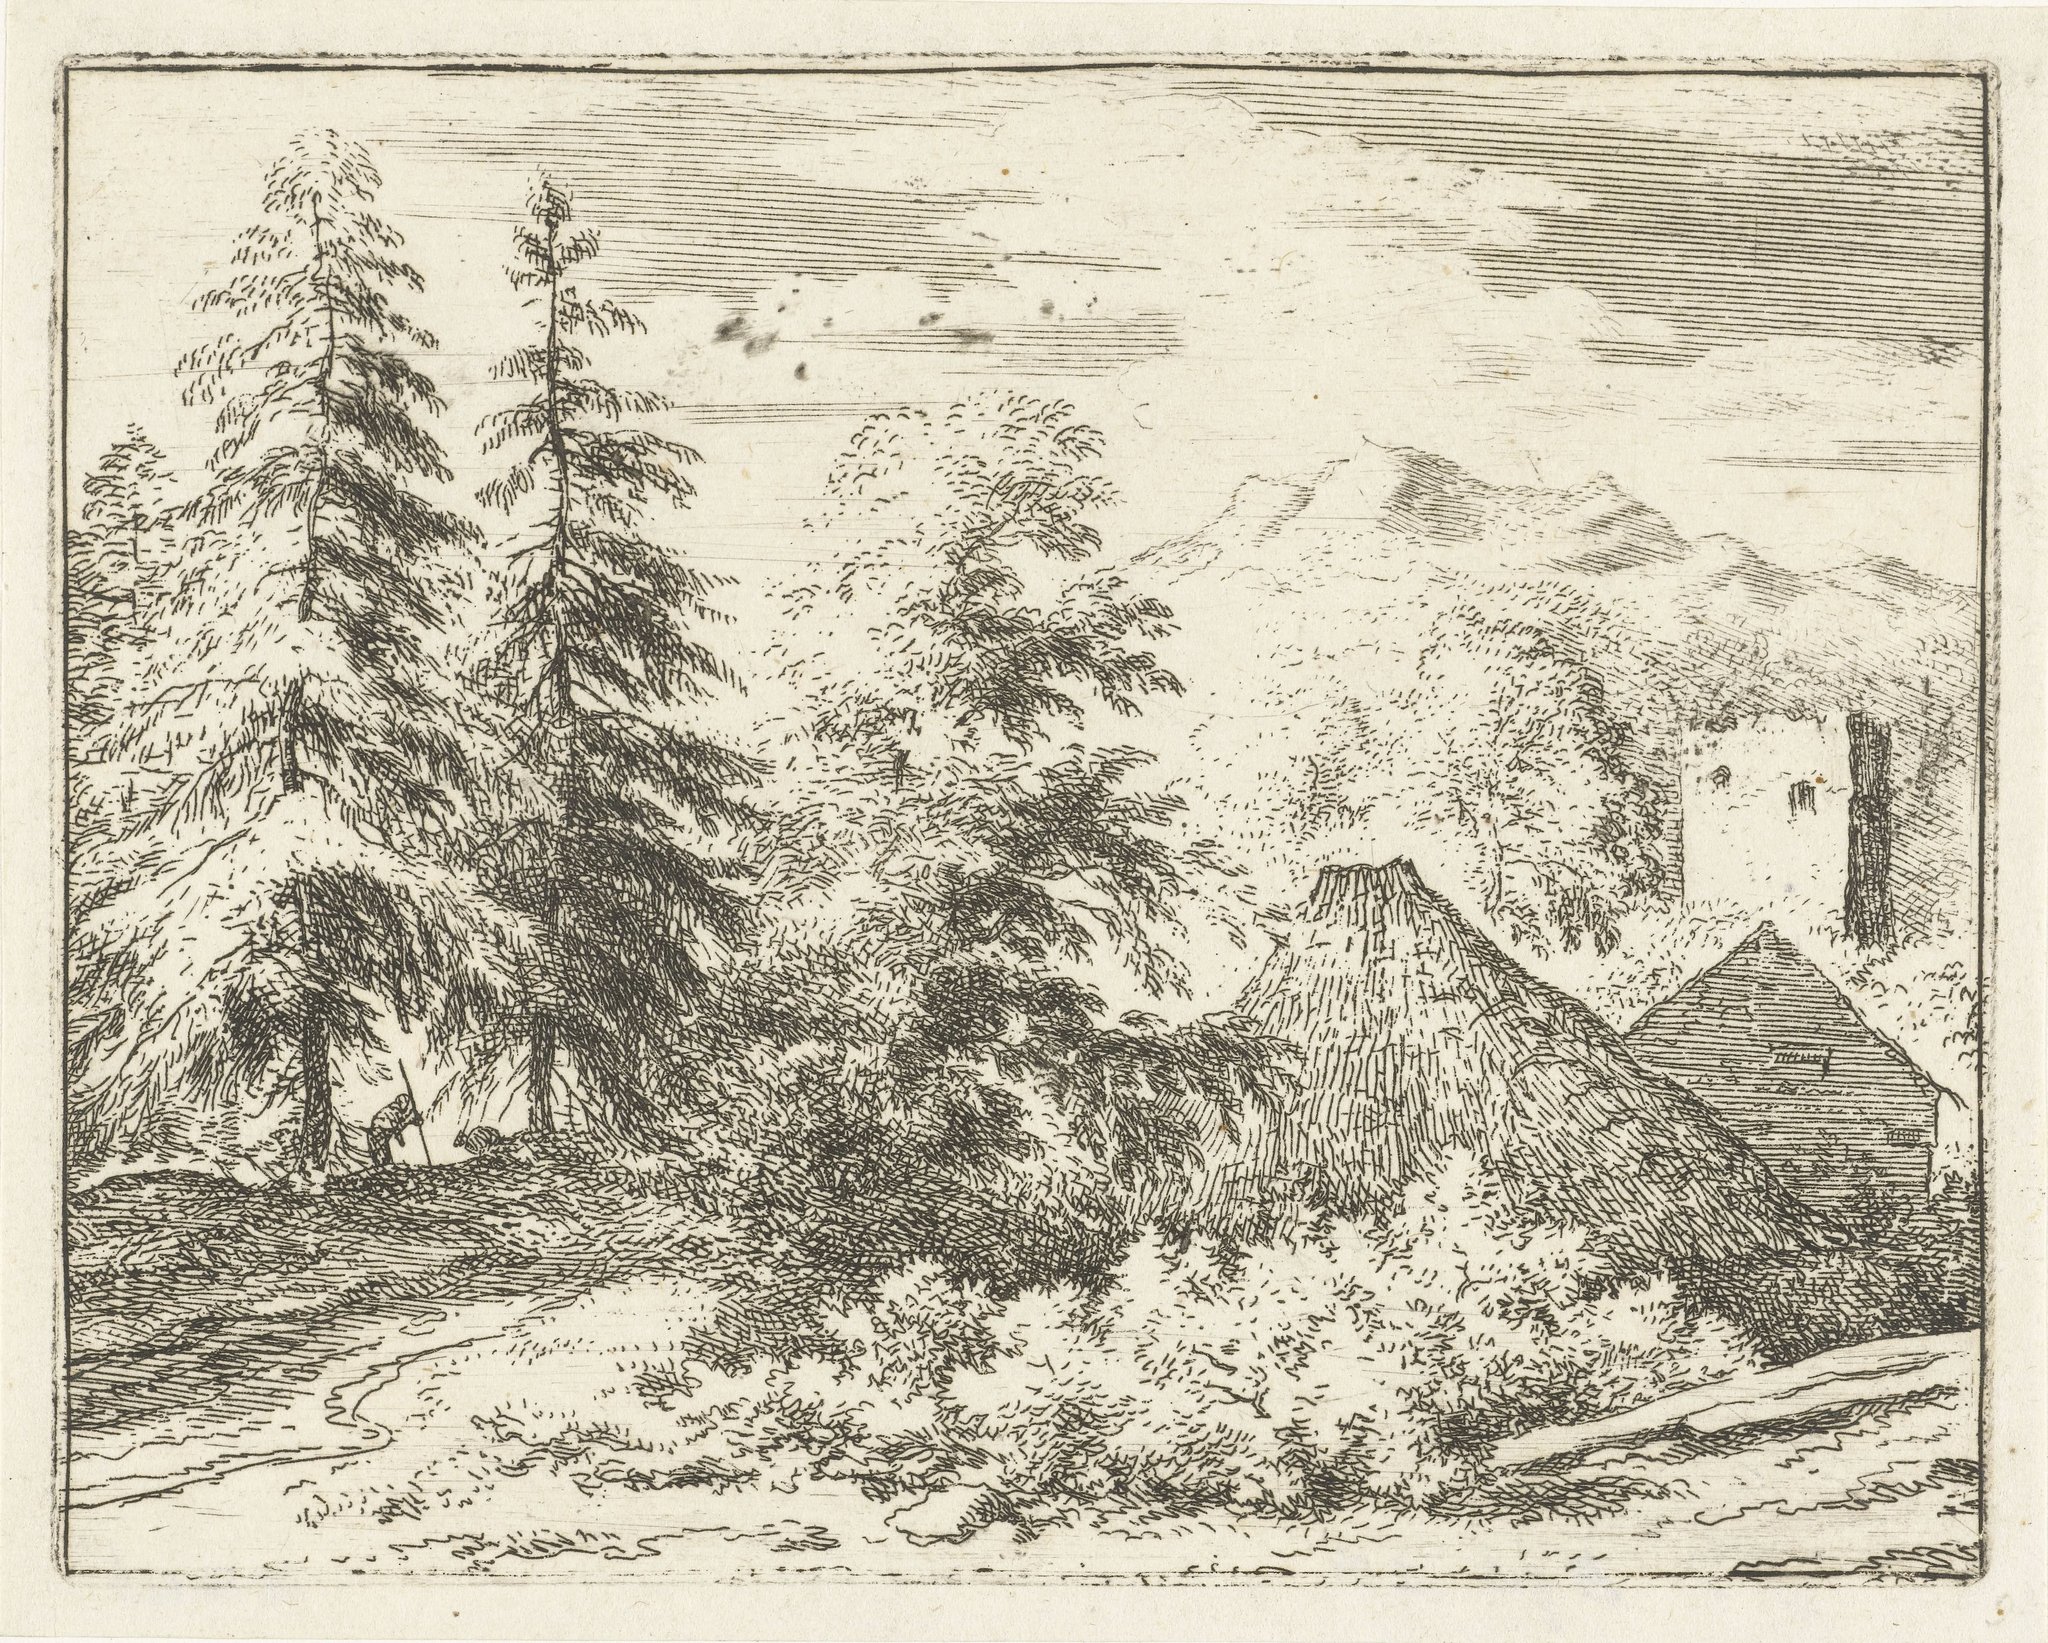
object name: print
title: Landschap met man tussen twee sparren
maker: allaert van everdingen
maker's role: draughtsman, painter, print maker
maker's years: 1621-1675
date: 1631-1675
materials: paper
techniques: etching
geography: netherlands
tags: trees: fir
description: Landschap met de daken van twee huizen zichtbaar tussen bomen en struikgewas. Tussen twee hoge sparren op de achtergrond staat een man met een stok.